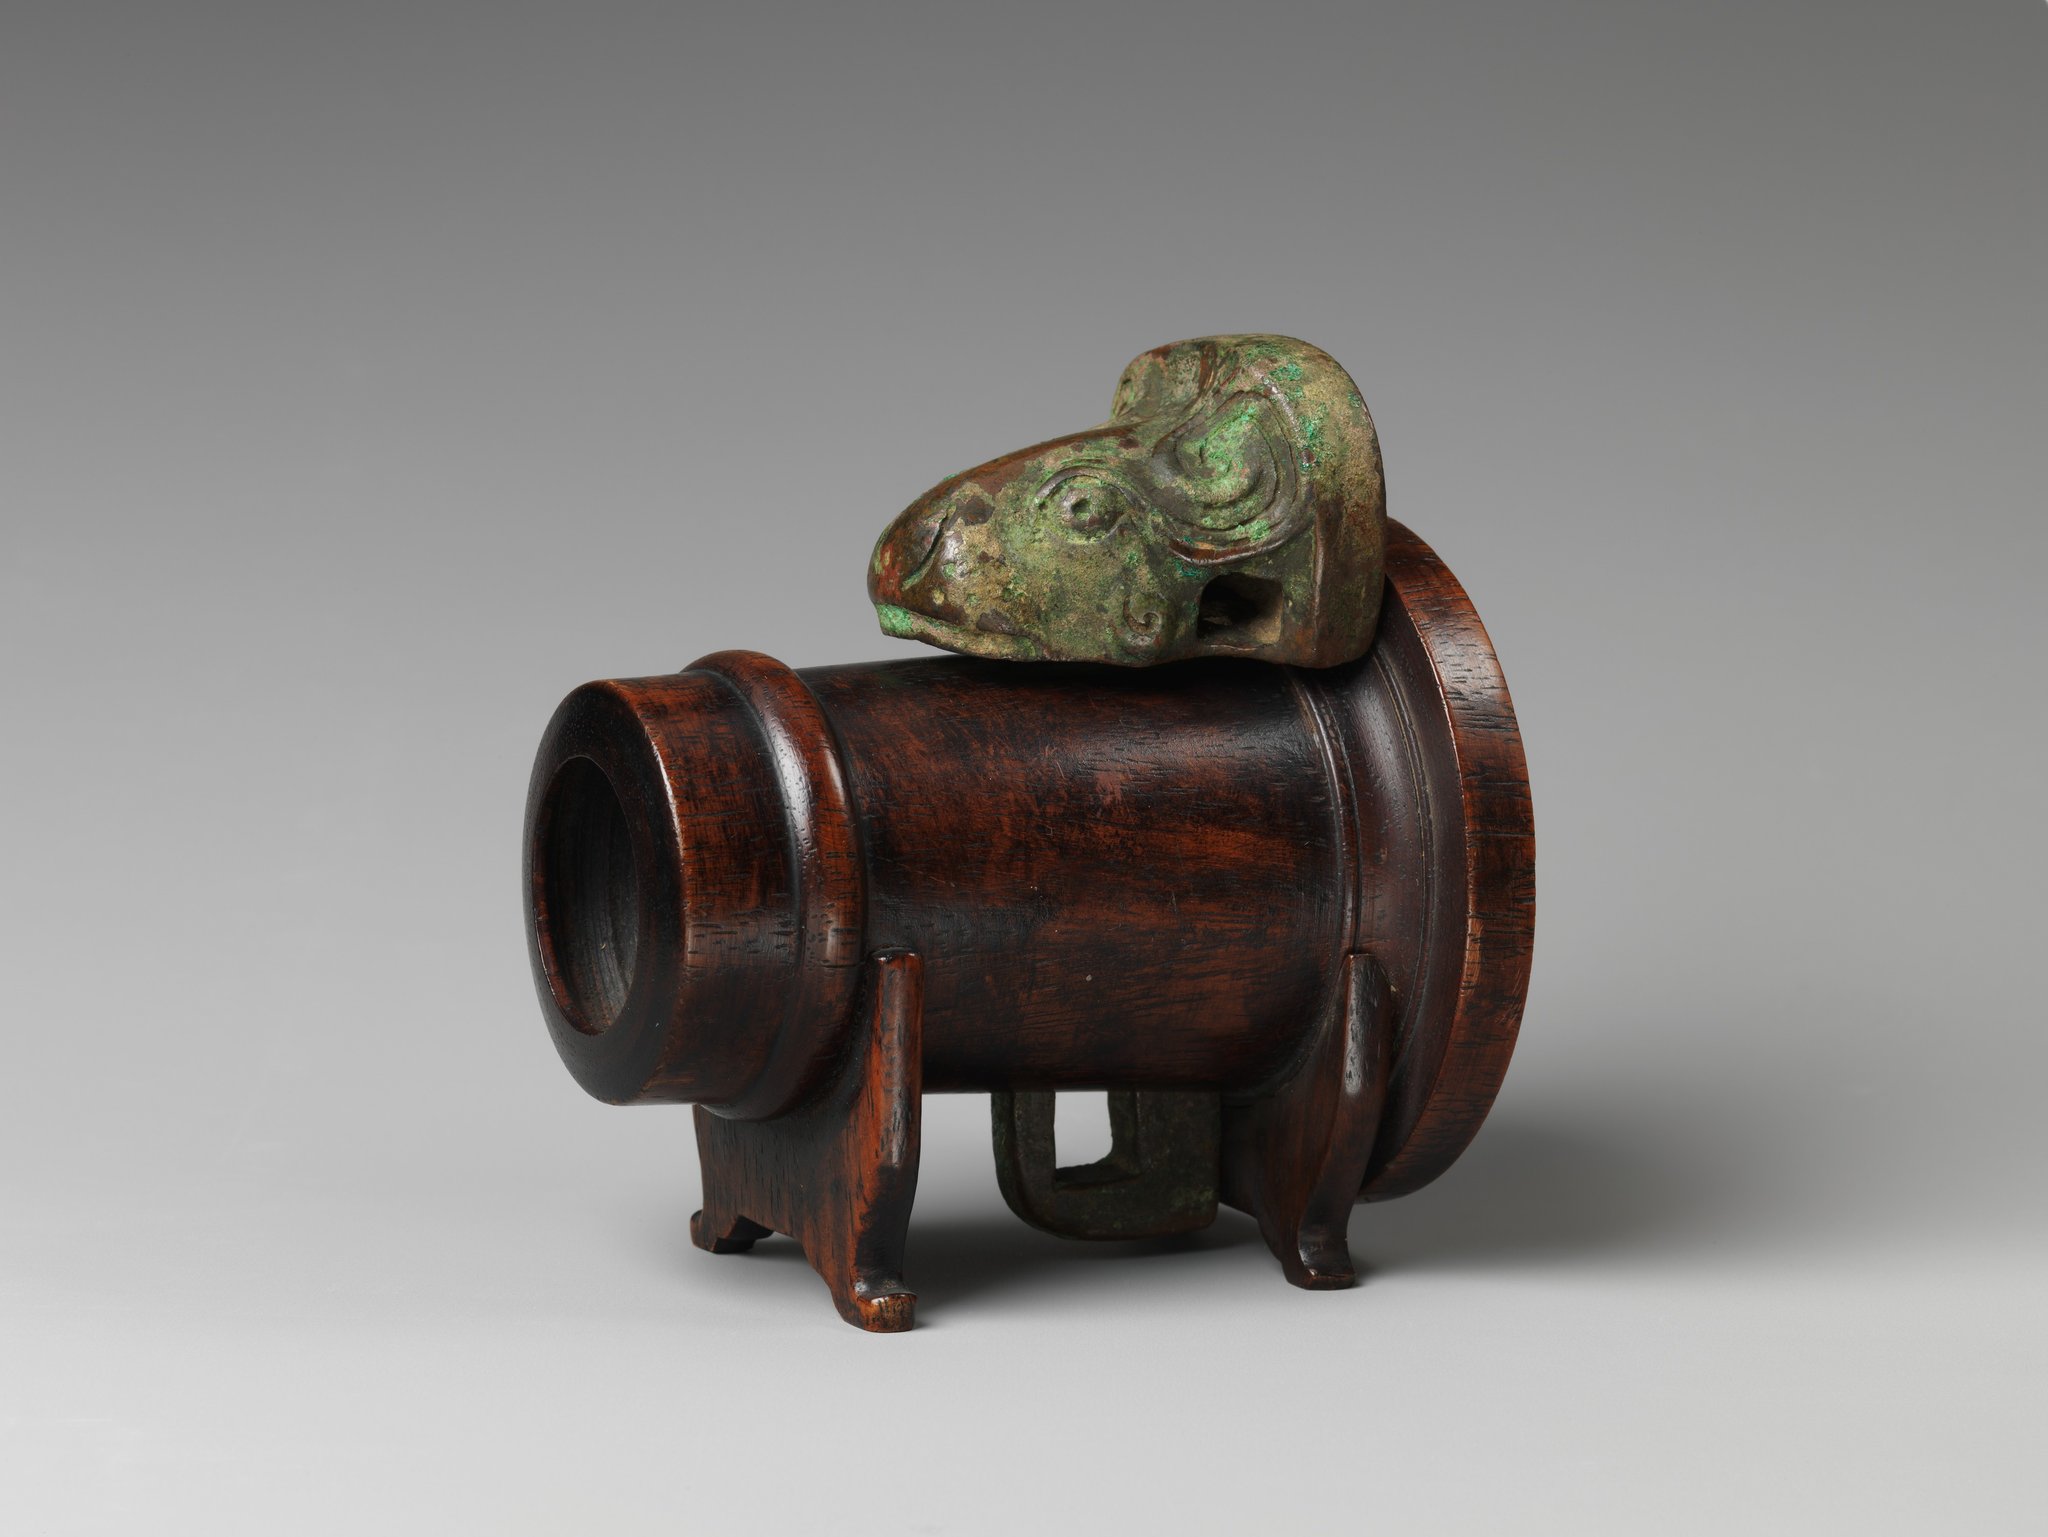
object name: chariot fitting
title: Two axle pins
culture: chinese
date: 900-801 BCE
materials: bronze